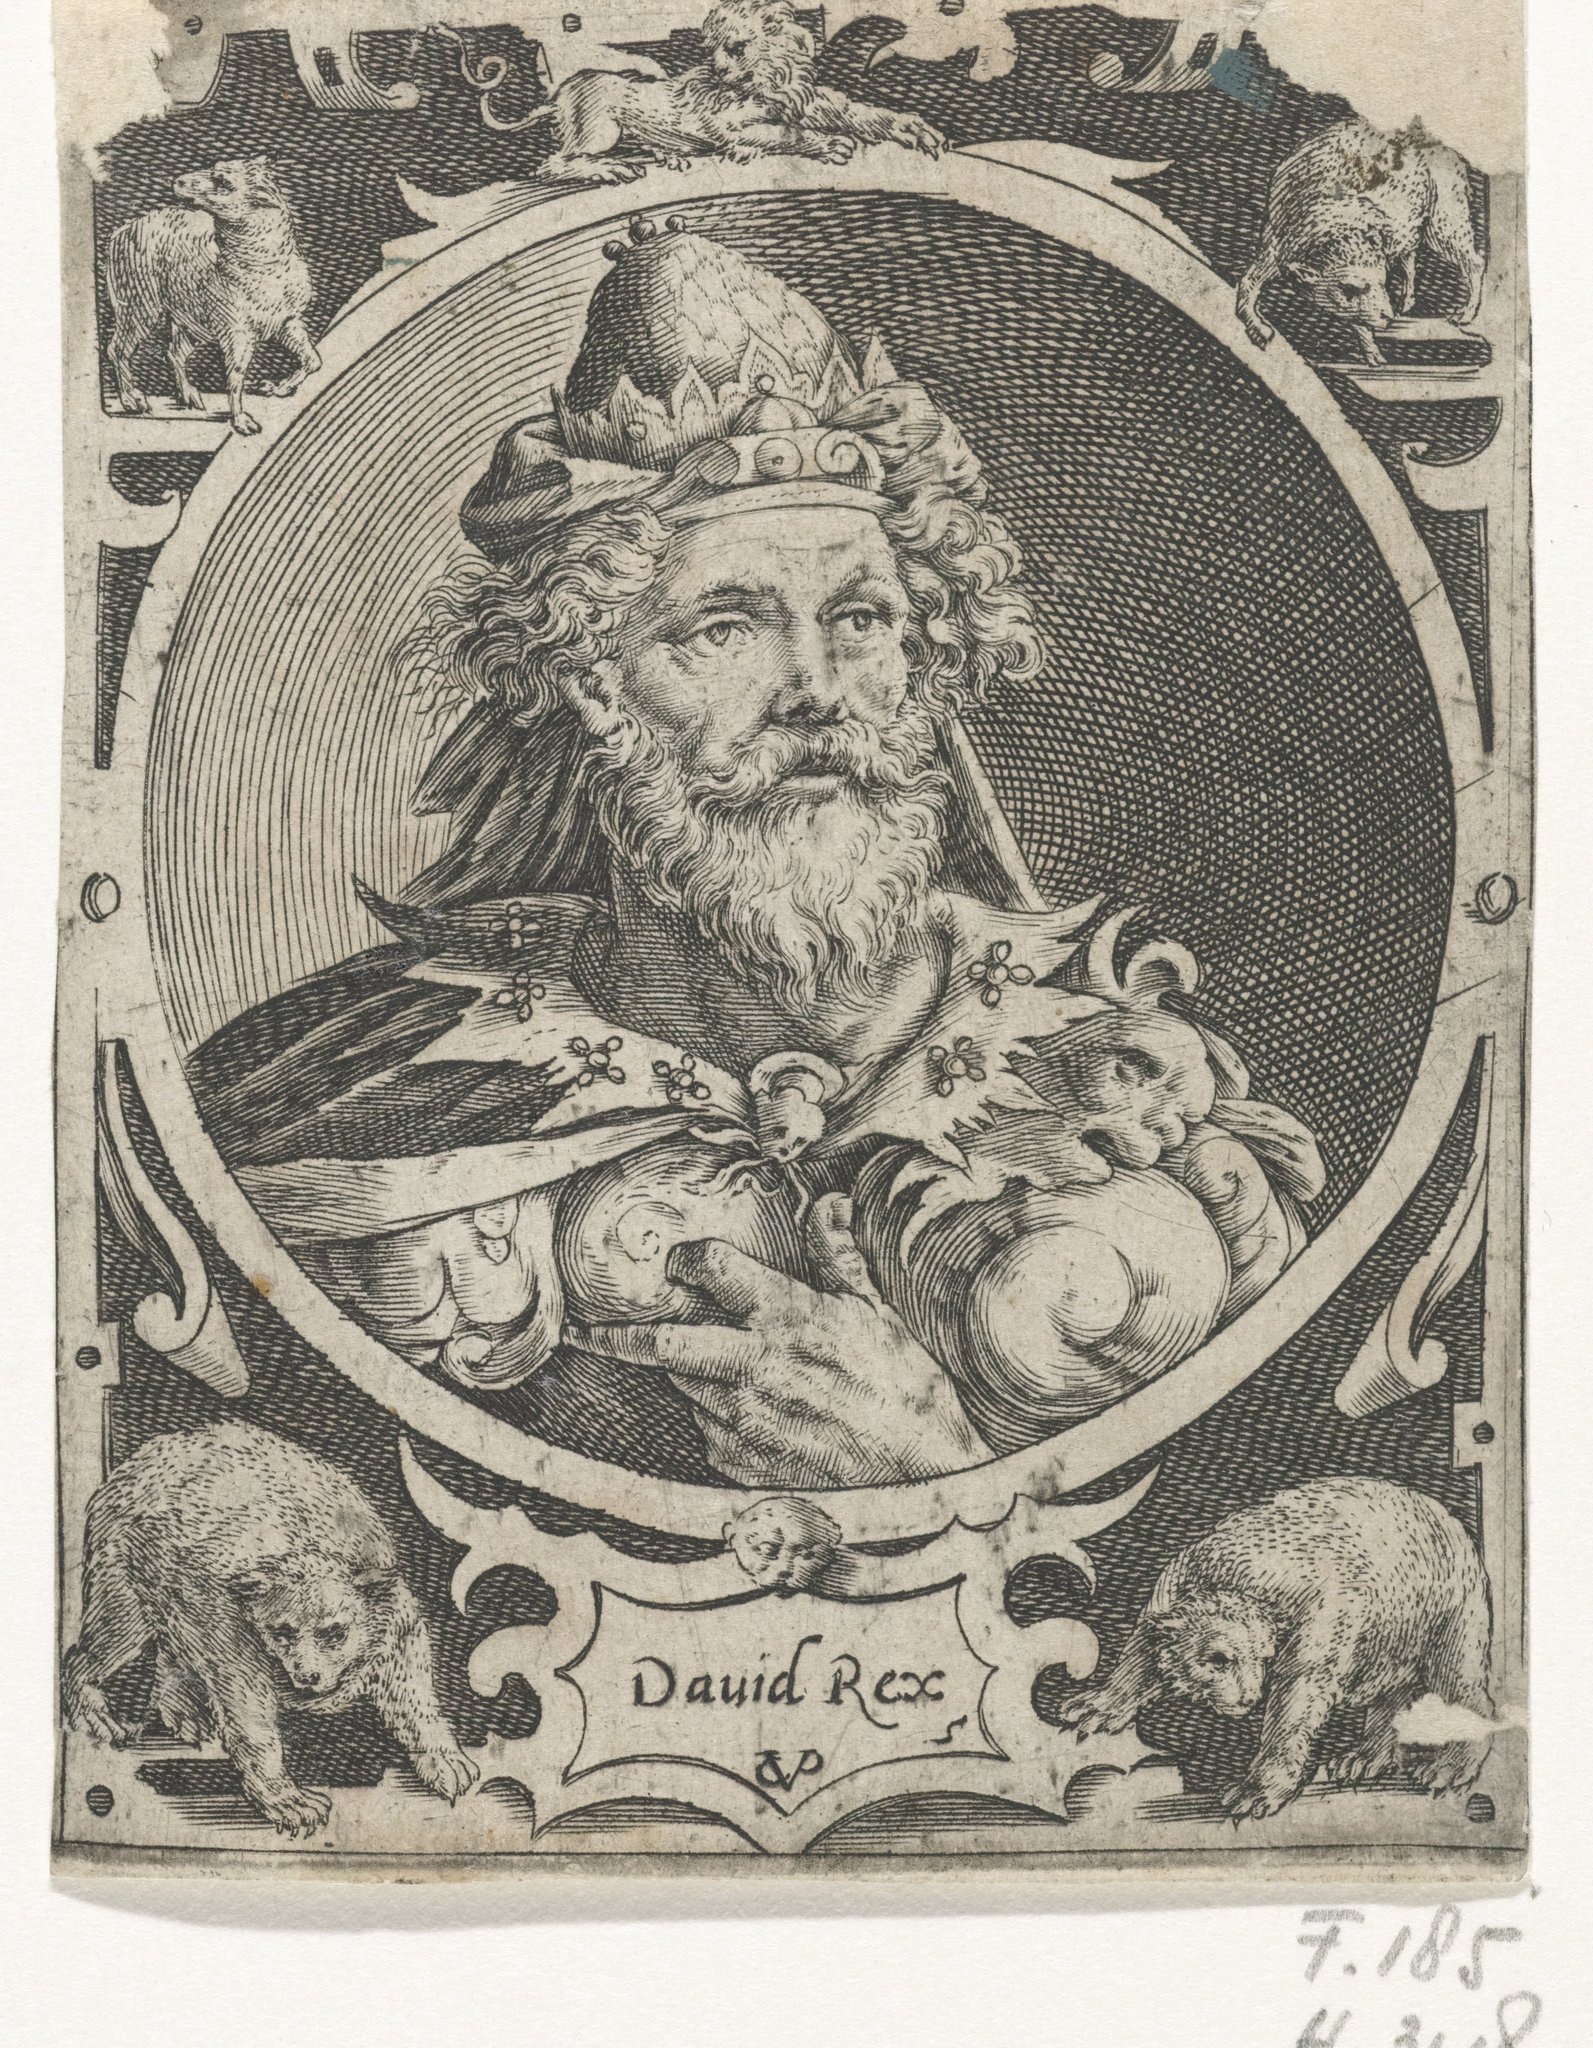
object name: print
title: De negen helden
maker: crispijn van de passe (i)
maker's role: draughtsman, print maker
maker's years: 1564-1637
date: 1574-1637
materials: paper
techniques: engraving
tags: david (one of the nine worthies)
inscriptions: collector's mark: Lugt 2228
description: De Joodse held David. Buste gevat in een medaillon met daaronder een cartouche met zijn naam. In de onderhoeken twee beren en in de bovenhoeken twee schapen en een leeuw. Prent uit een serie van negen met helden.